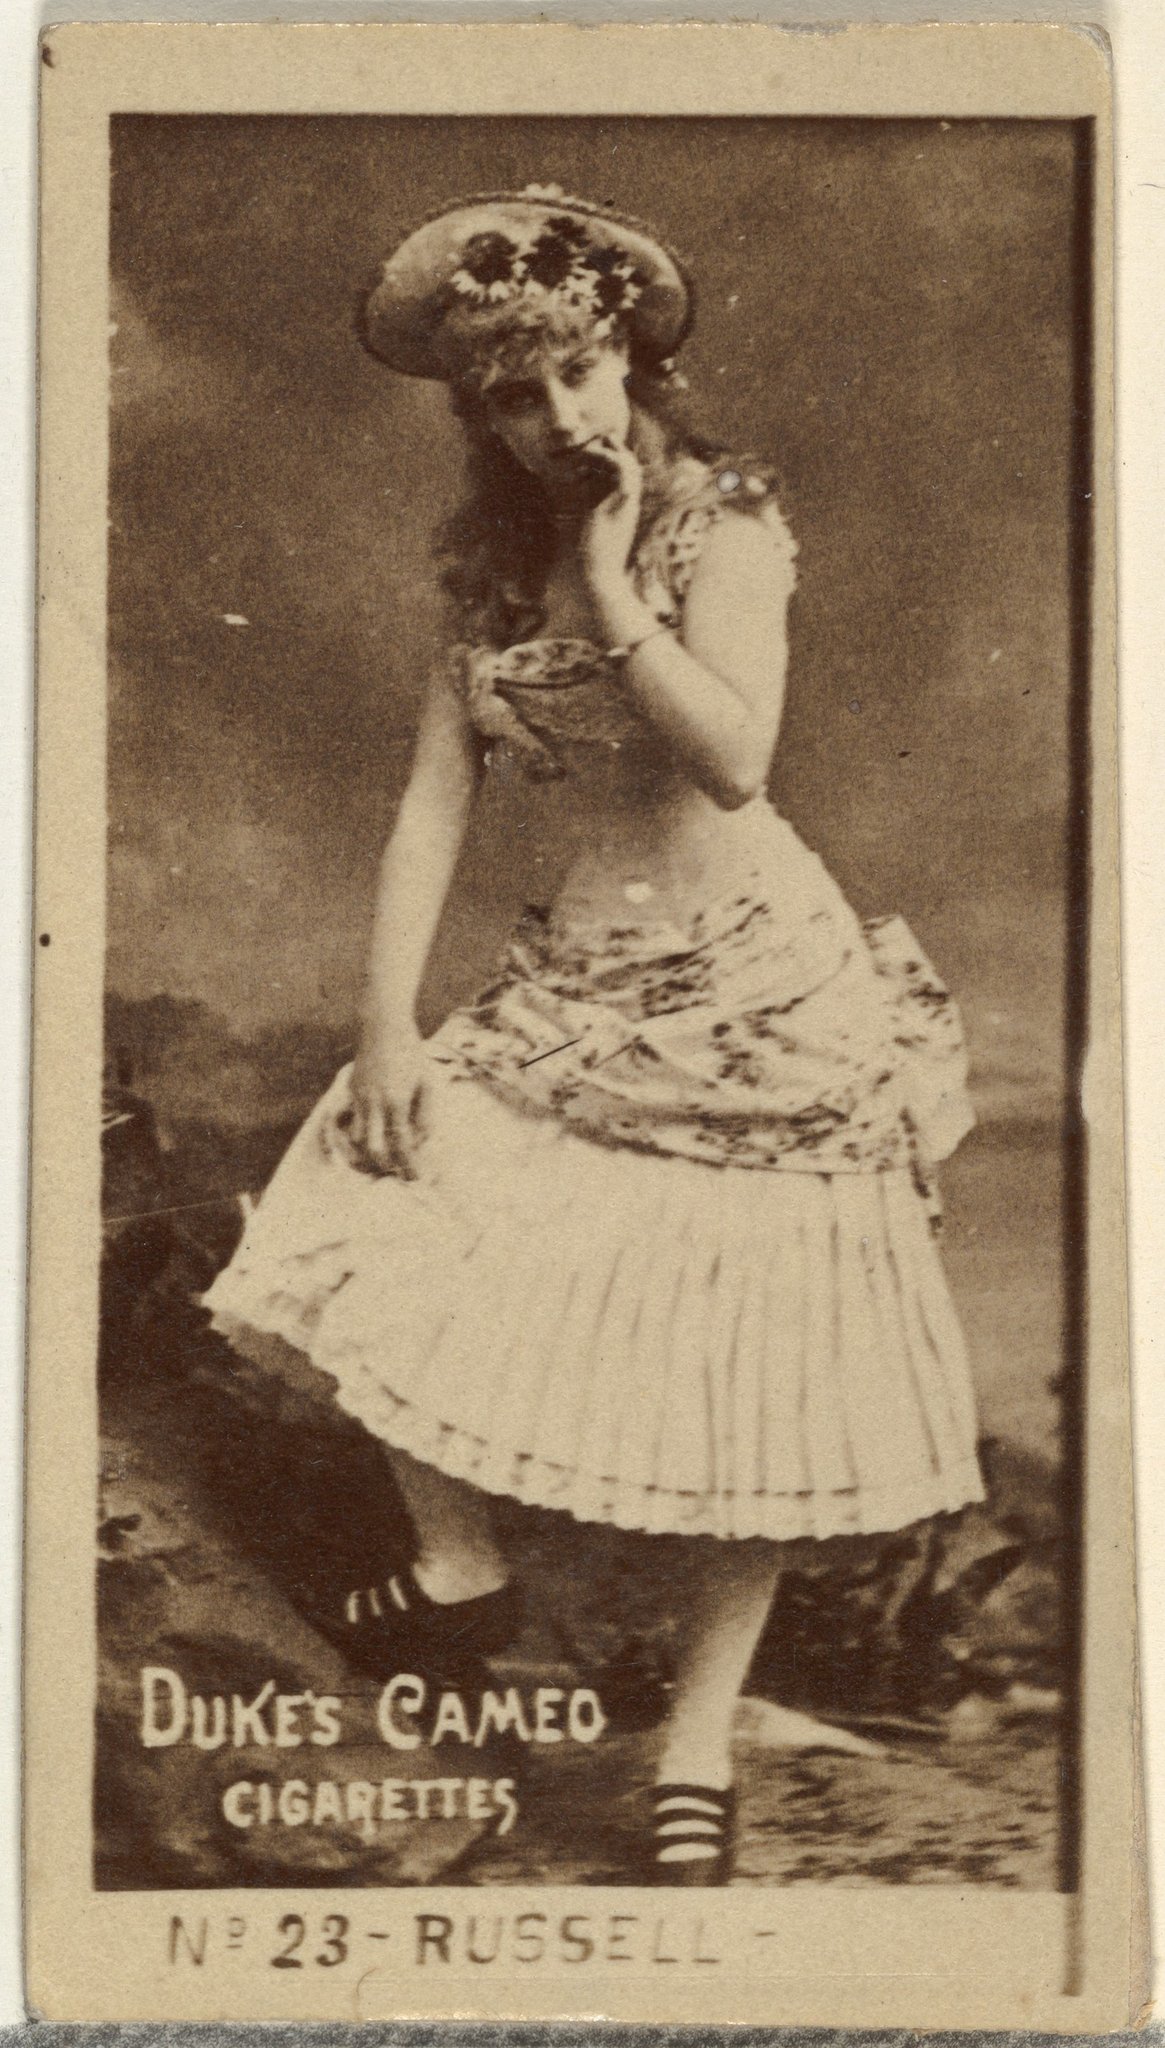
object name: photograph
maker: w. duke, sons & co.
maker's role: publisher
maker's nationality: american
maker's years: 1870-1920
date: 1880-1889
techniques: albumen silver print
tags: portraits,women,actresses